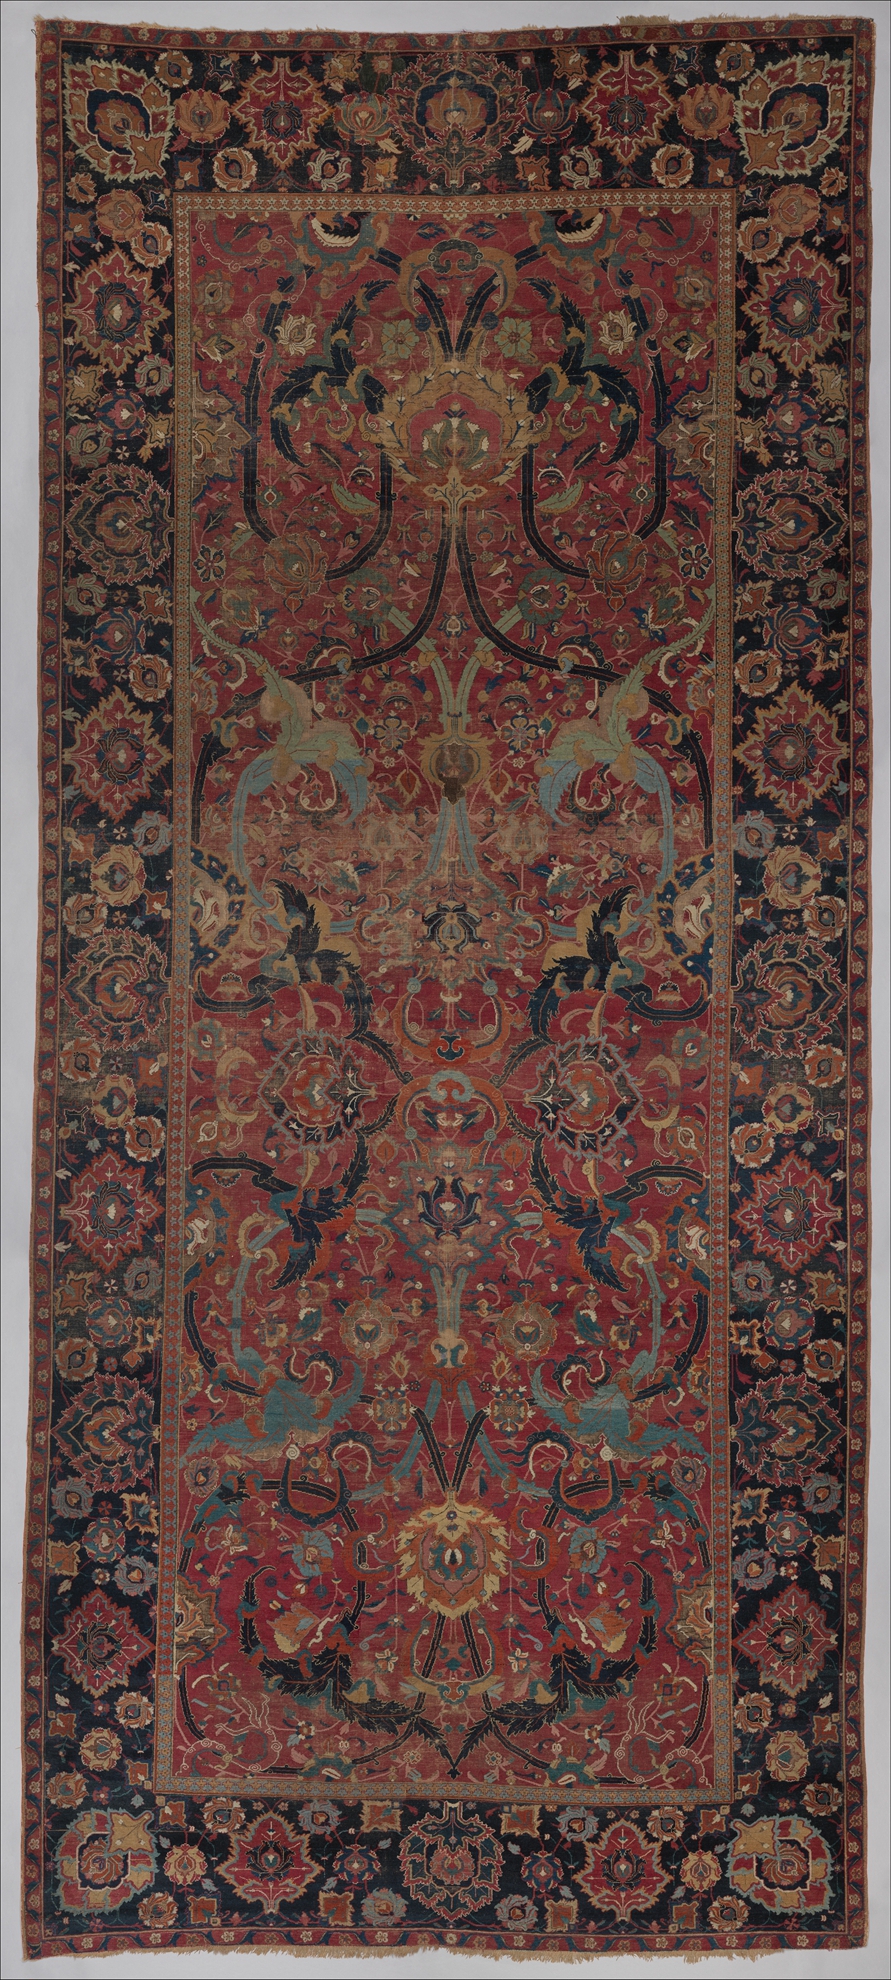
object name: carpet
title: Floral Arabesque Carpet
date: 1601-1700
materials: cotton, wool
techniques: asymmetrically knotted pile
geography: iran